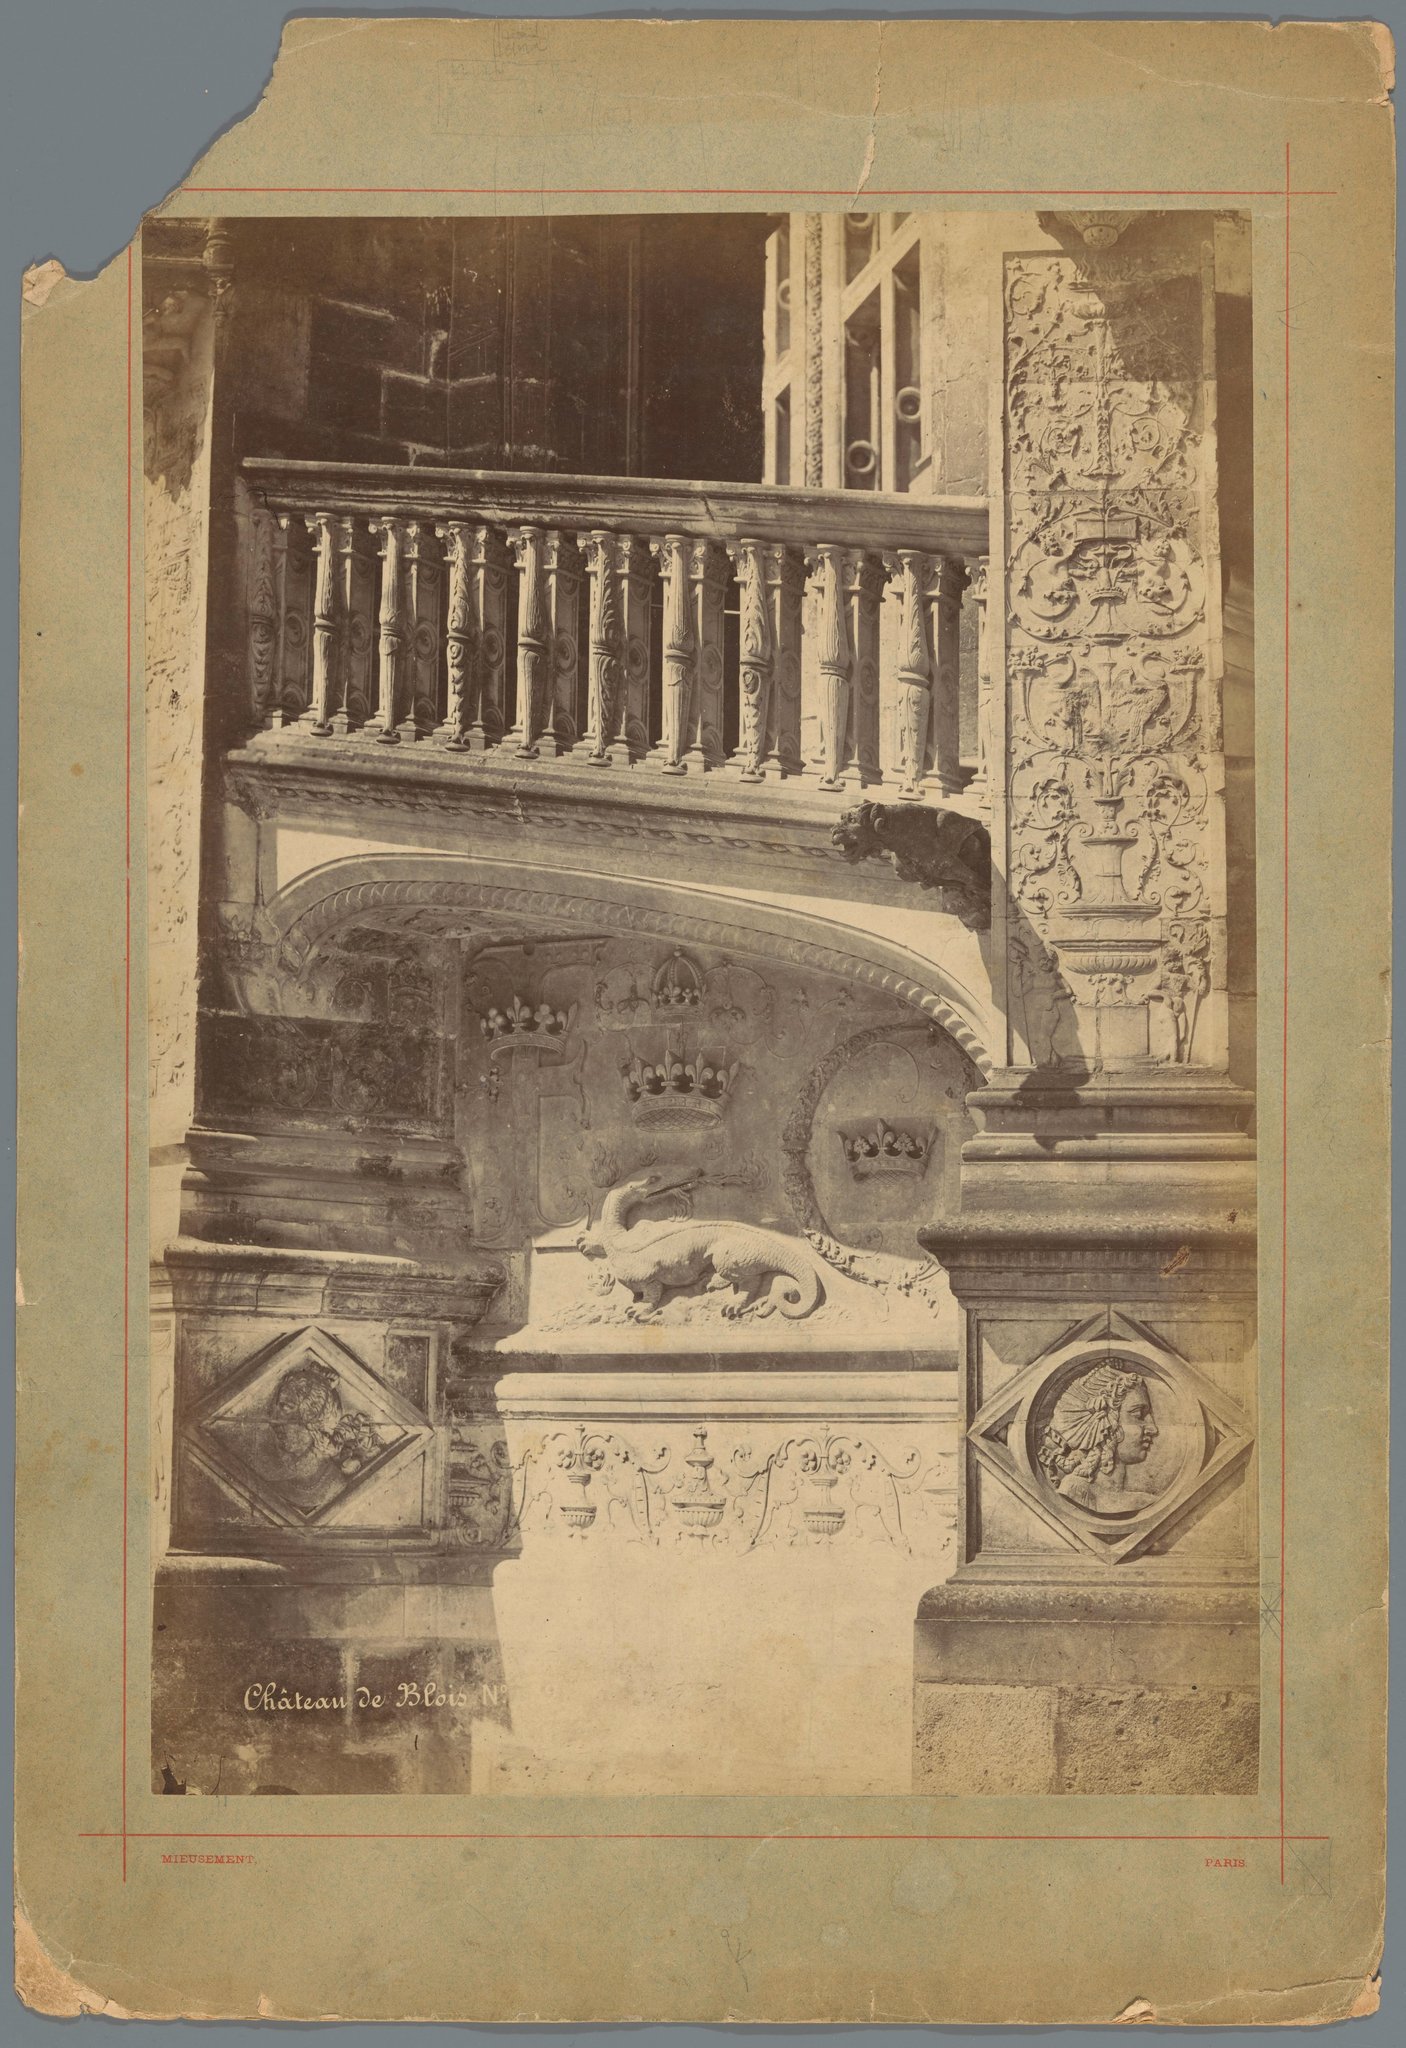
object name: photograph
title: Château de Blois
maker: séraphin-médéric mieusement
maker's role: fotograaf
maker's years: 1840-1905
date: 1875-1900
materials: cardboard, photographic support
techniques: albumen print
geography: blois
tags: salamander (fabulous animal); salamander as spirit of fire, staircase, ornament derived from plant forms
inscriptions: collector's mark: Lugt 3937, name: ‘Monsters worden door de Representant J. A. G. de Leur den Haag op franco aanvrage verzonden’, number: ‘No. [...]39’